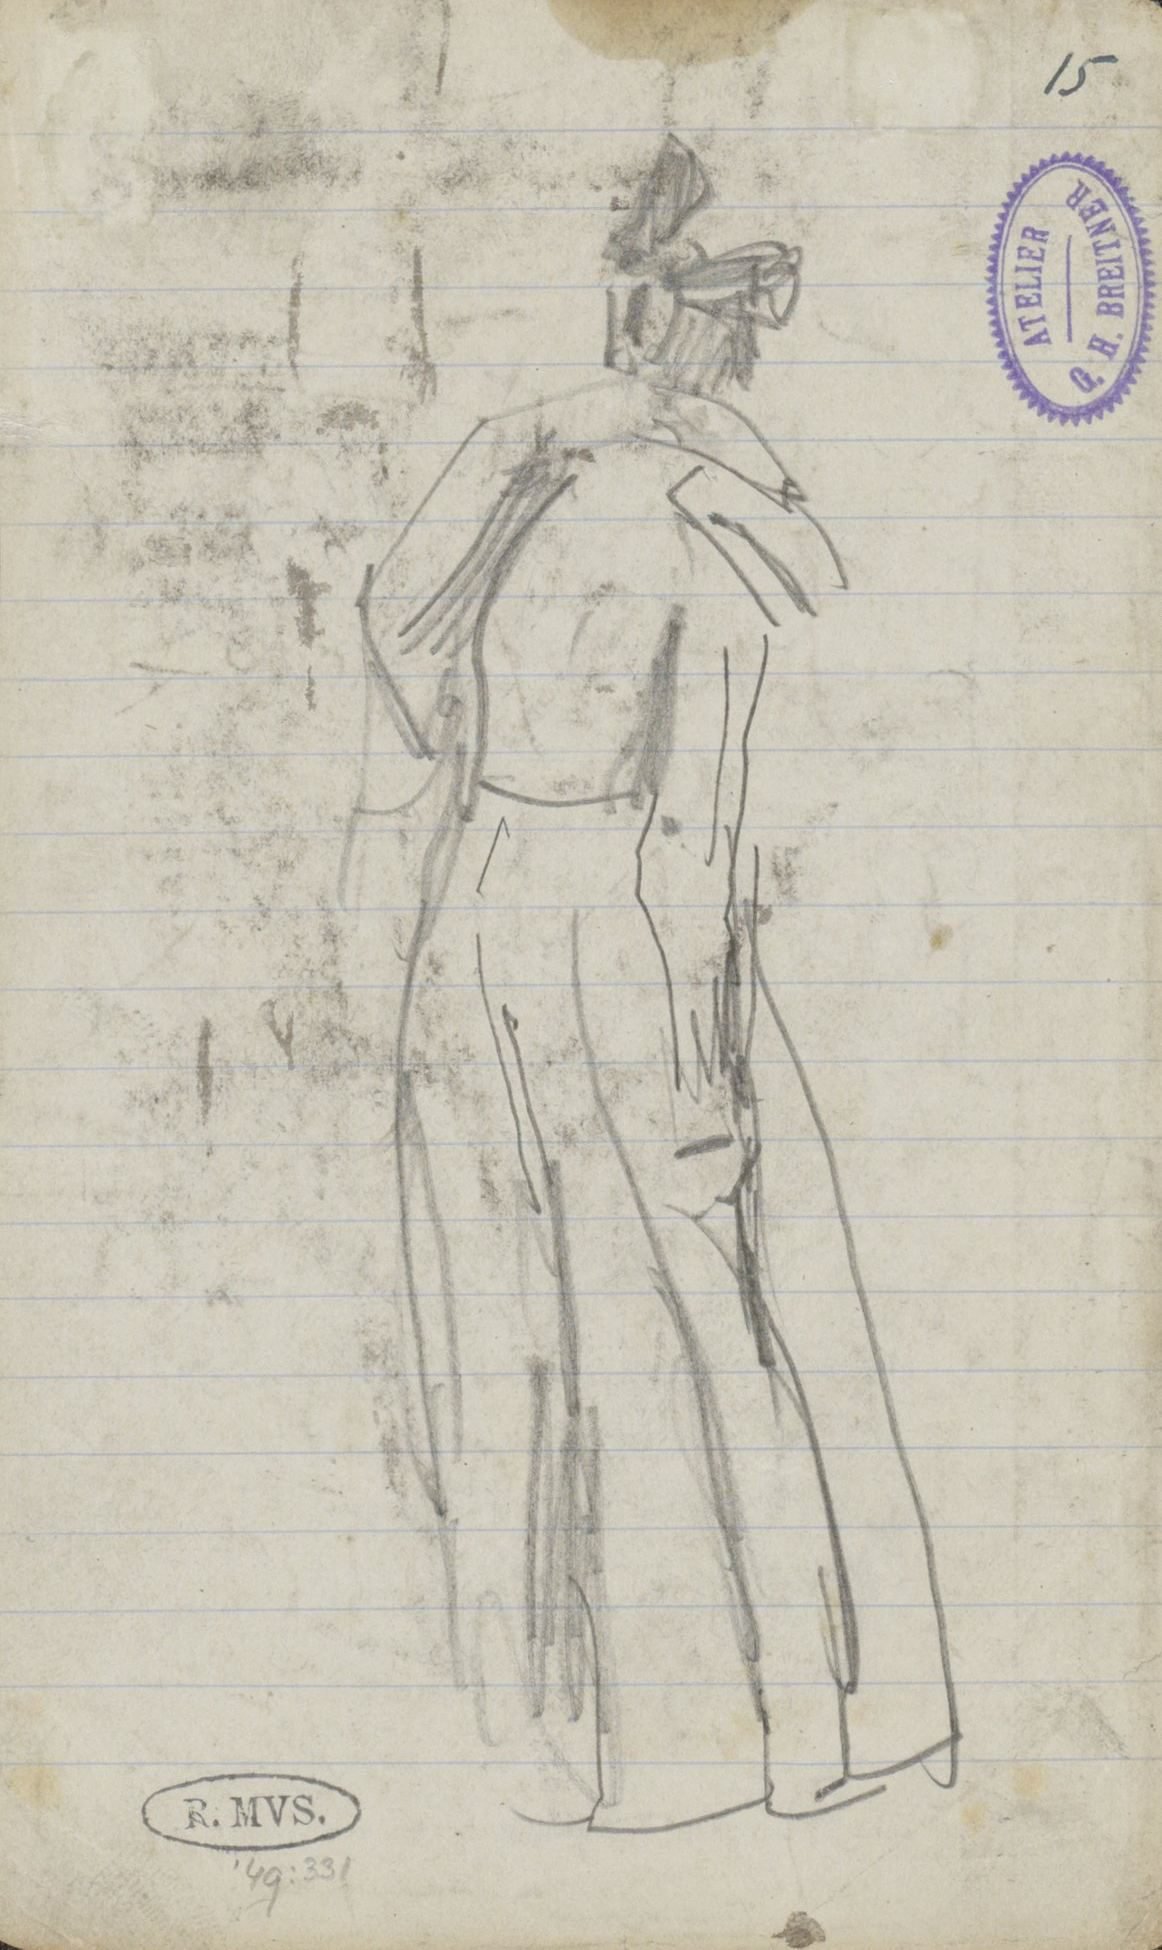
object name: drawing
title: Staande vrouw, op de rug gezien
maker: george hendrik breitner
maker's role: draughtsman, painter, print maker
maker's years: 1857-1923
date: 1888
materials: pencil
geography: amsterdam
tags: adult woman (+ standing)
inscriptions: collector's mark: Lugt 2228, workshop stamp: Lugt 291d